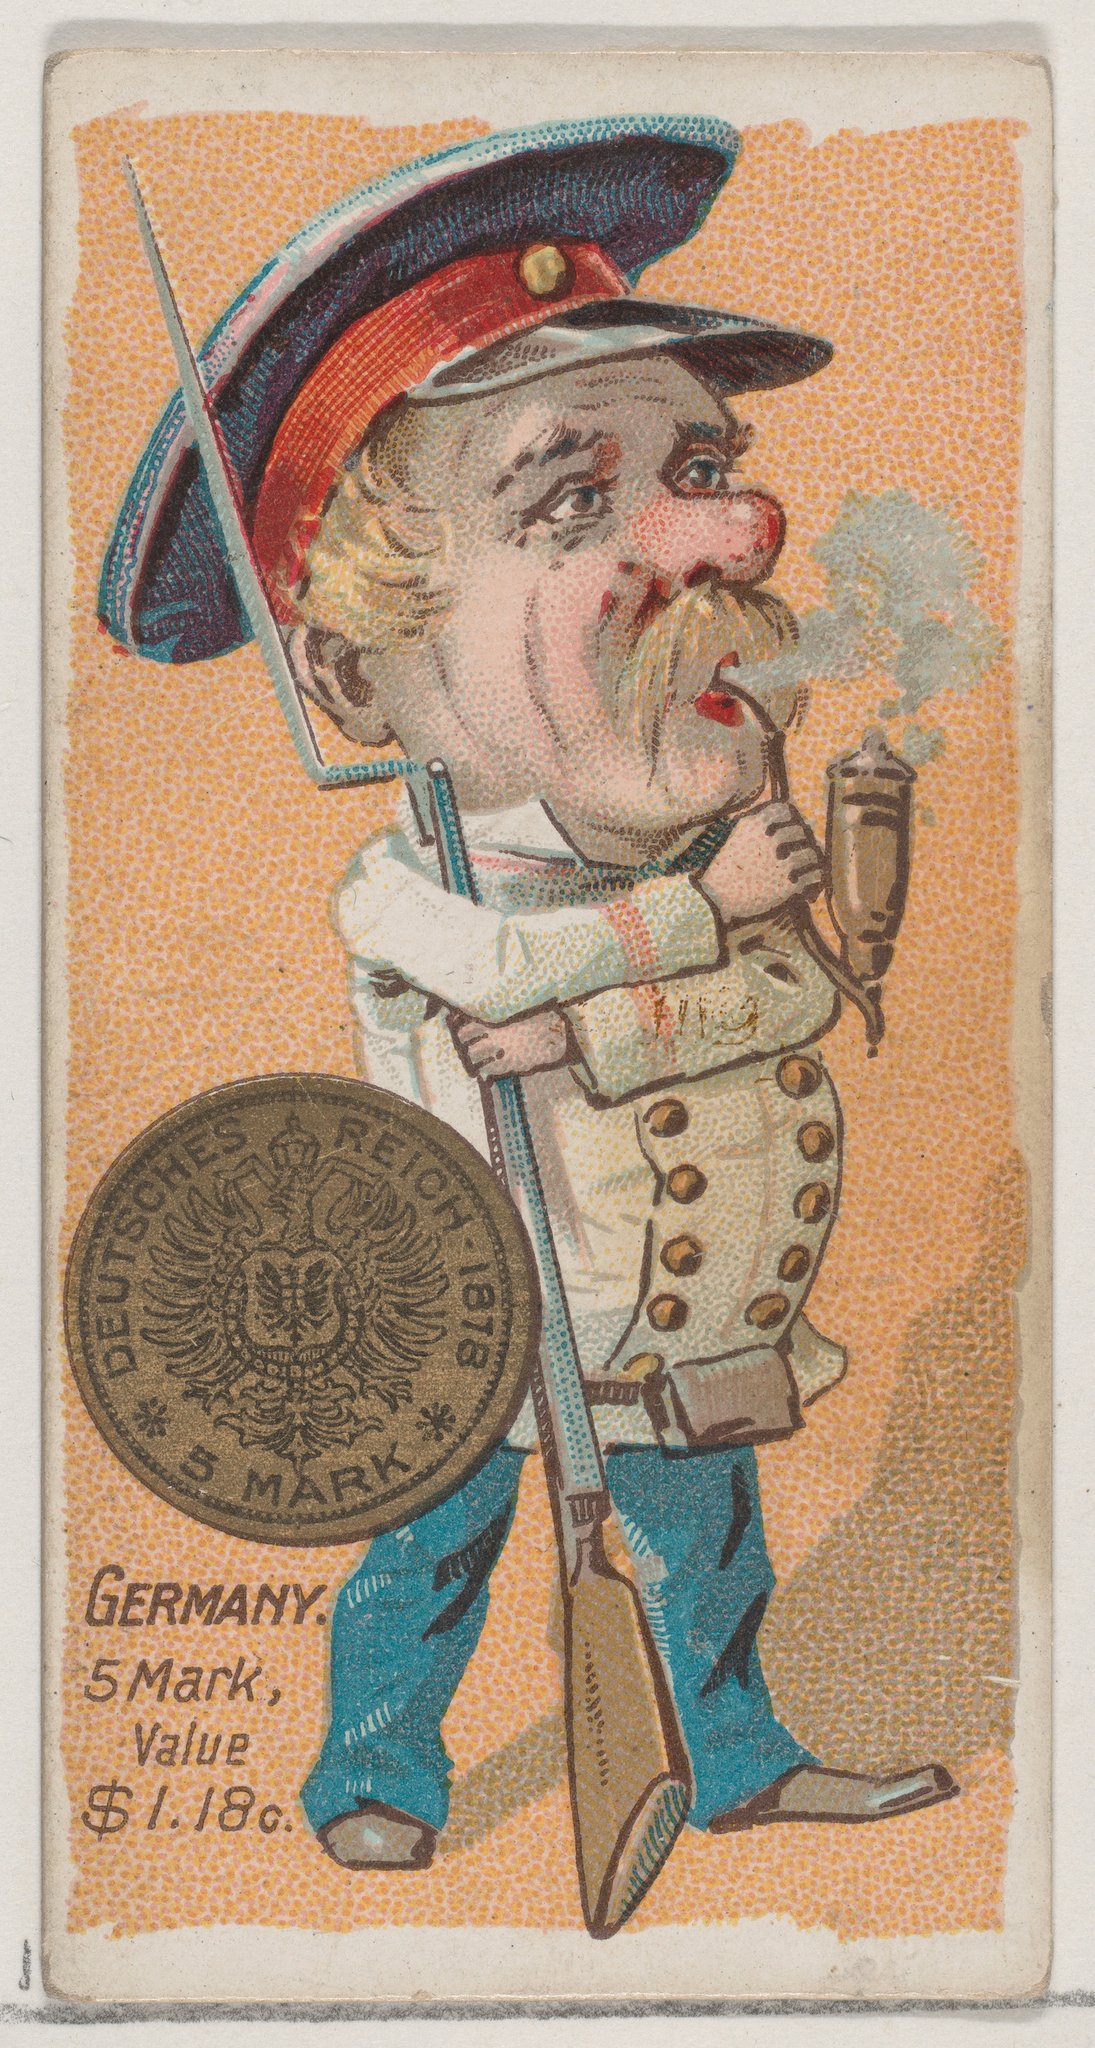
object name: print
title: Germany, 5 Mark, from the series Coins of All Nations (N72, variation 2) for Duke brand cigarettes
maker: w. duke, sons & co.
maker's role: publisher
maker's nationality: american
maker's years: 1870-1920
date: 1889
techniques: color lithograph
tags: men,coins